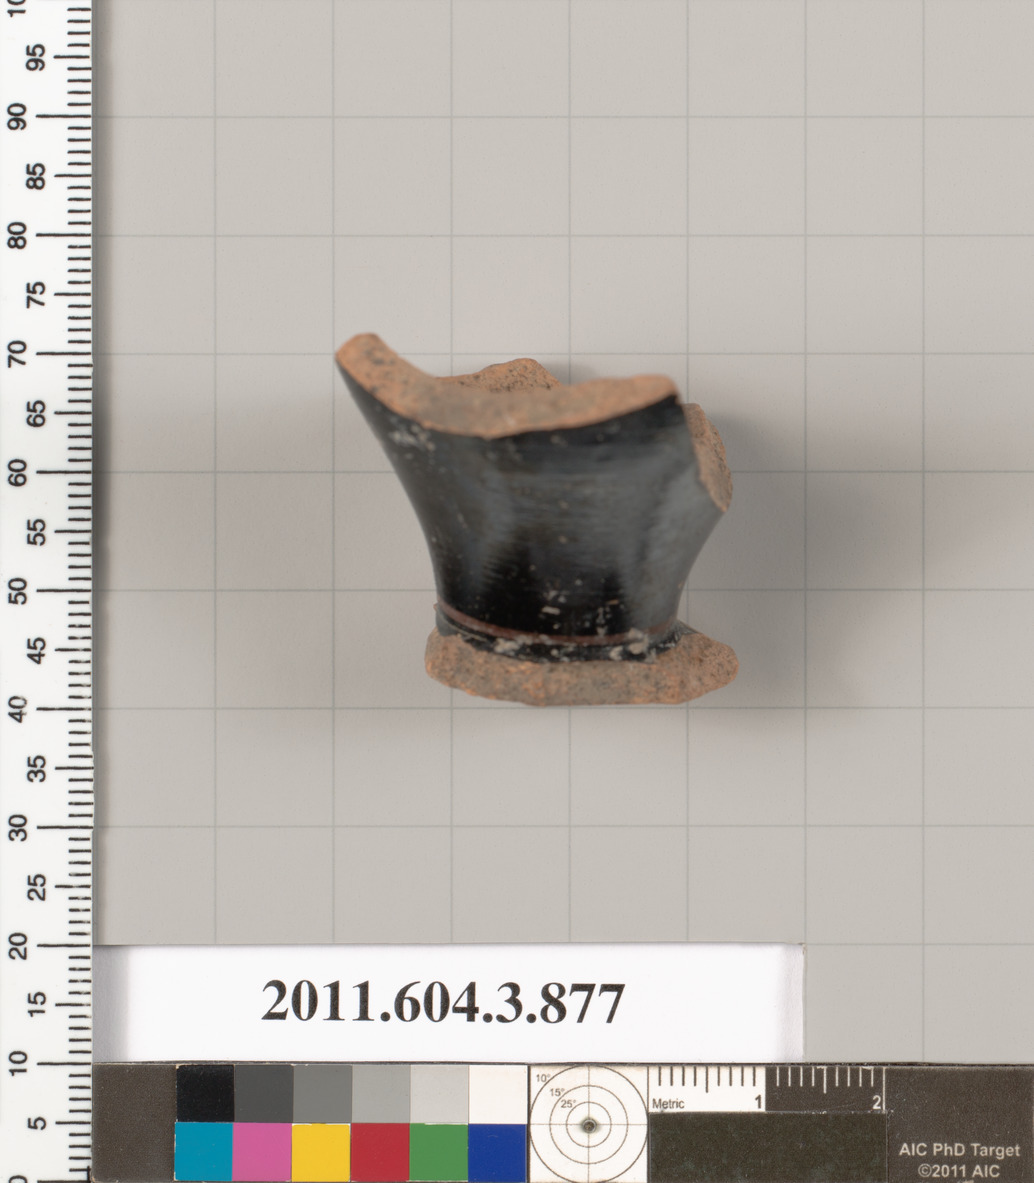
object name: lekythos fragment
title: Terracotta fragment of a lekythos (oil flask)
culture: greek, attic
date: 600-401 BCE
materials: terracotta